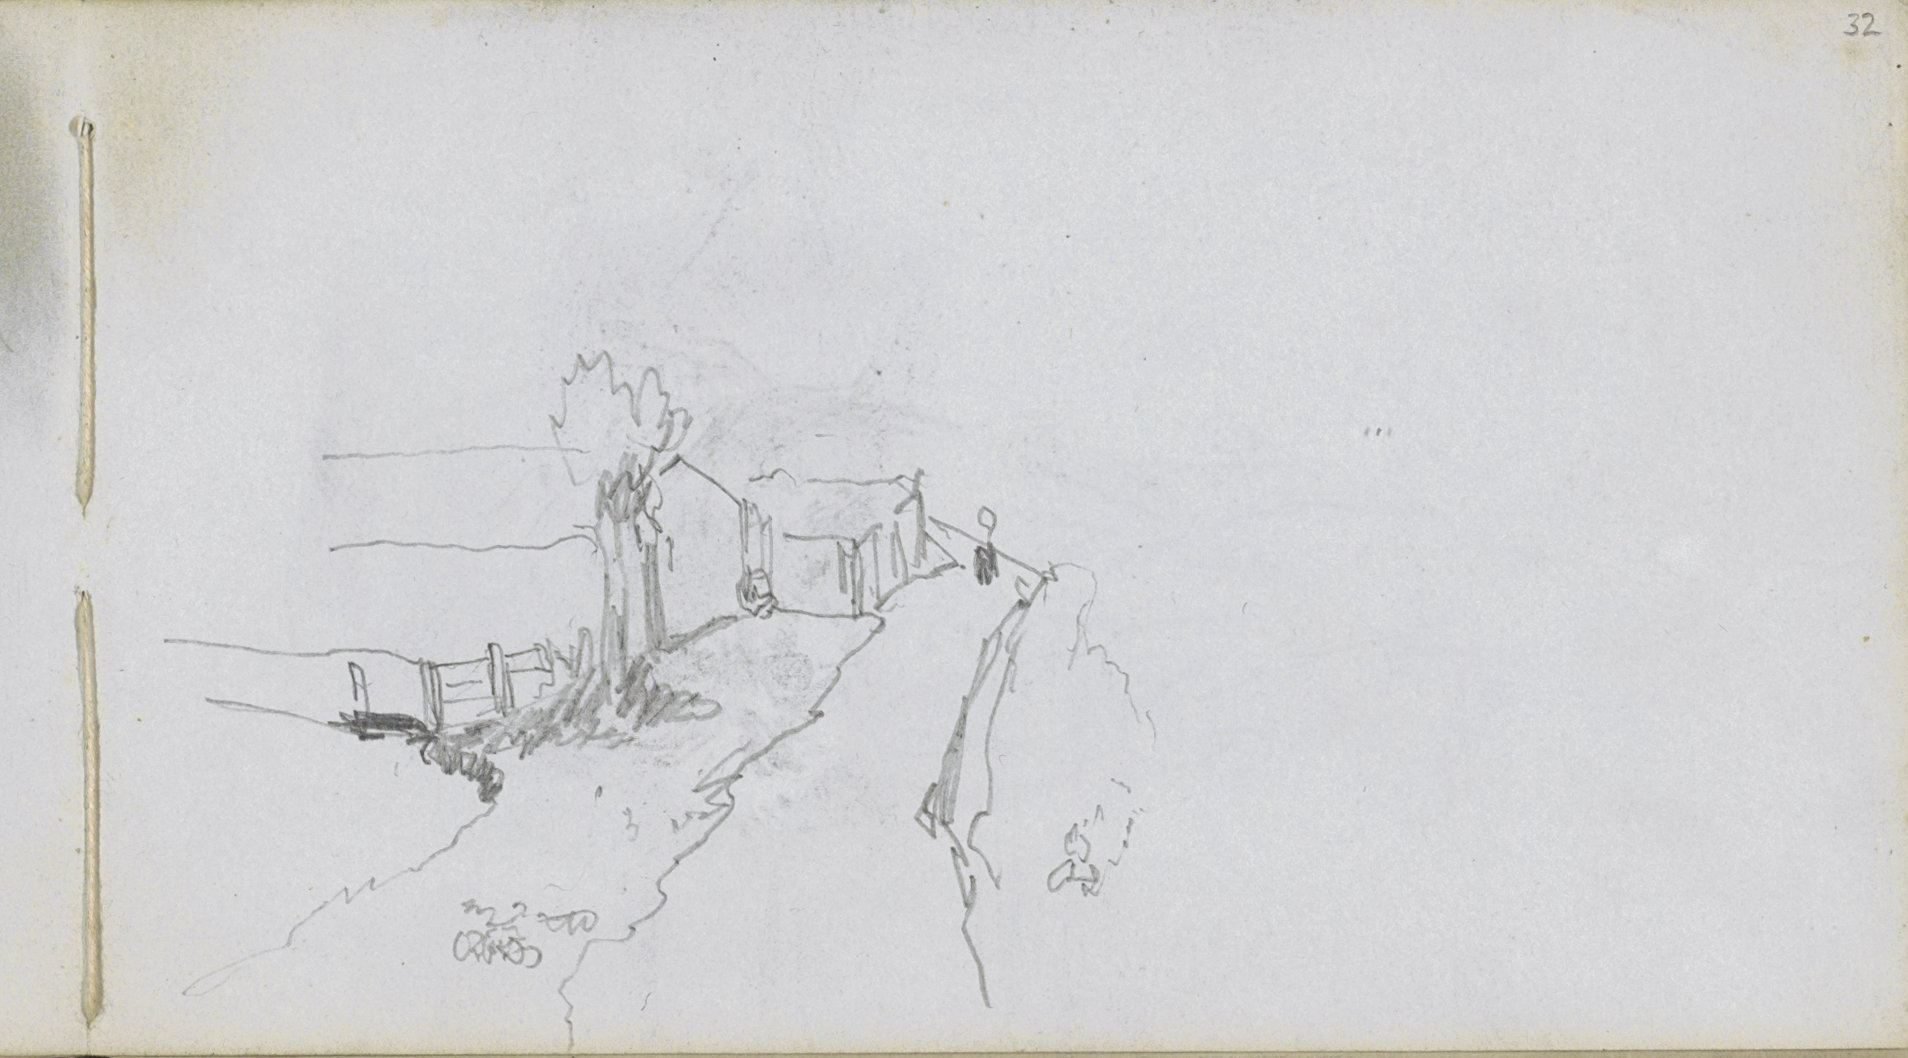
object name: sketchbook leaf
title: Plattelandswoning aan een weg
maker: johan hendrik weissenbruch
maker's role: draughtsman, painter, print maker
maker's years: 1824-1903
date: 1834-1903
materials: paper, pencil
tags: road, path, cottage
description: Blad 32 recto uit een schetsboek met 39 bladen.